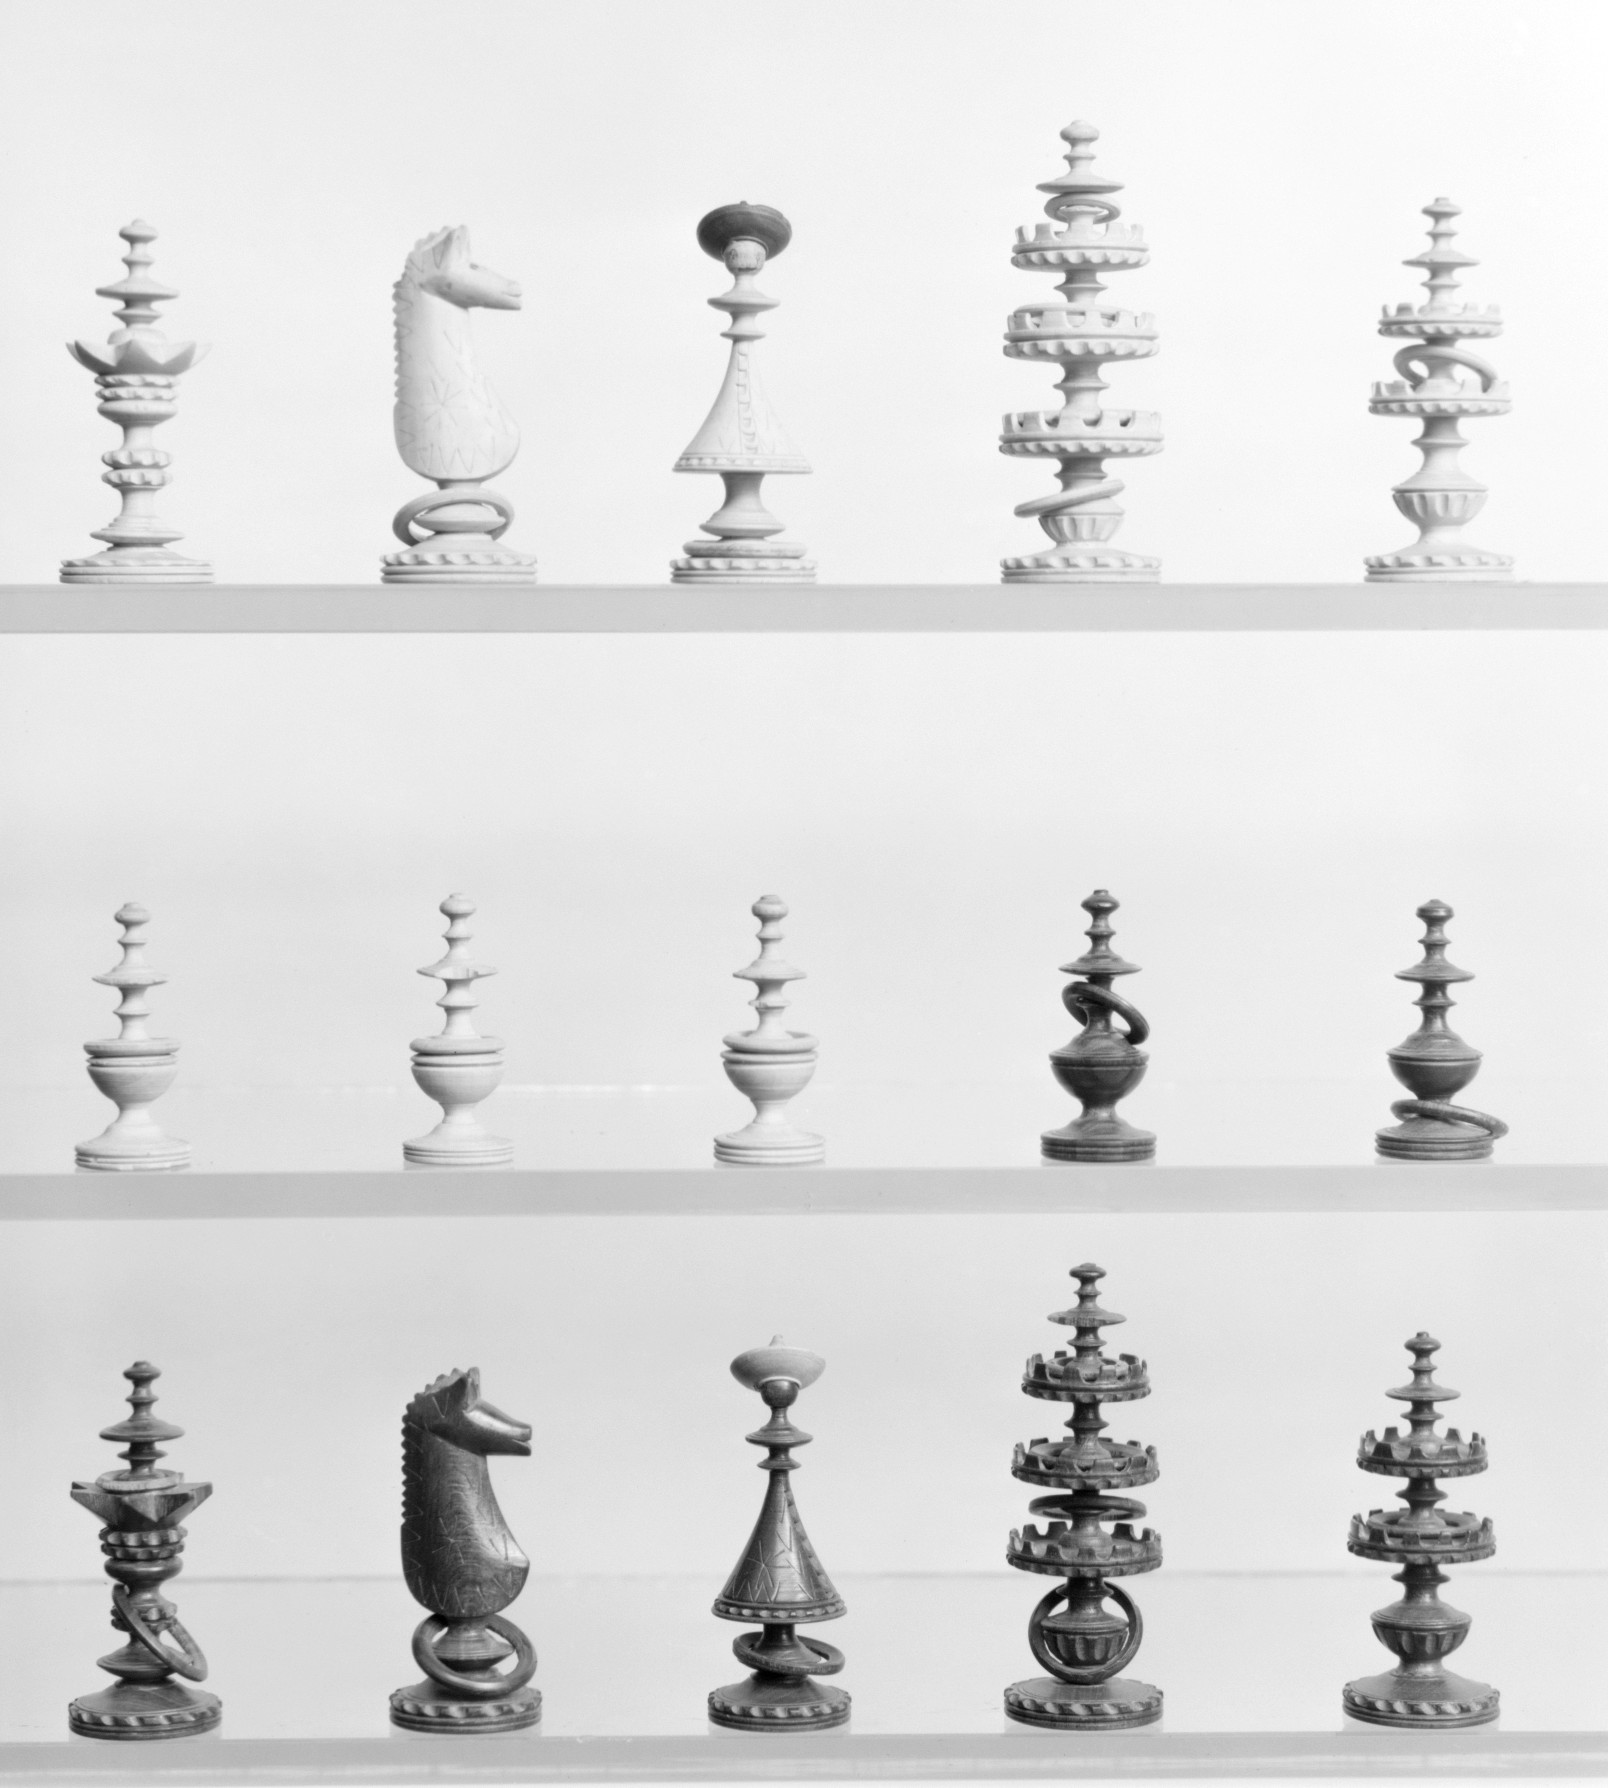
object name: chess set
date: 1885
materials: leather, wood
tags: chess